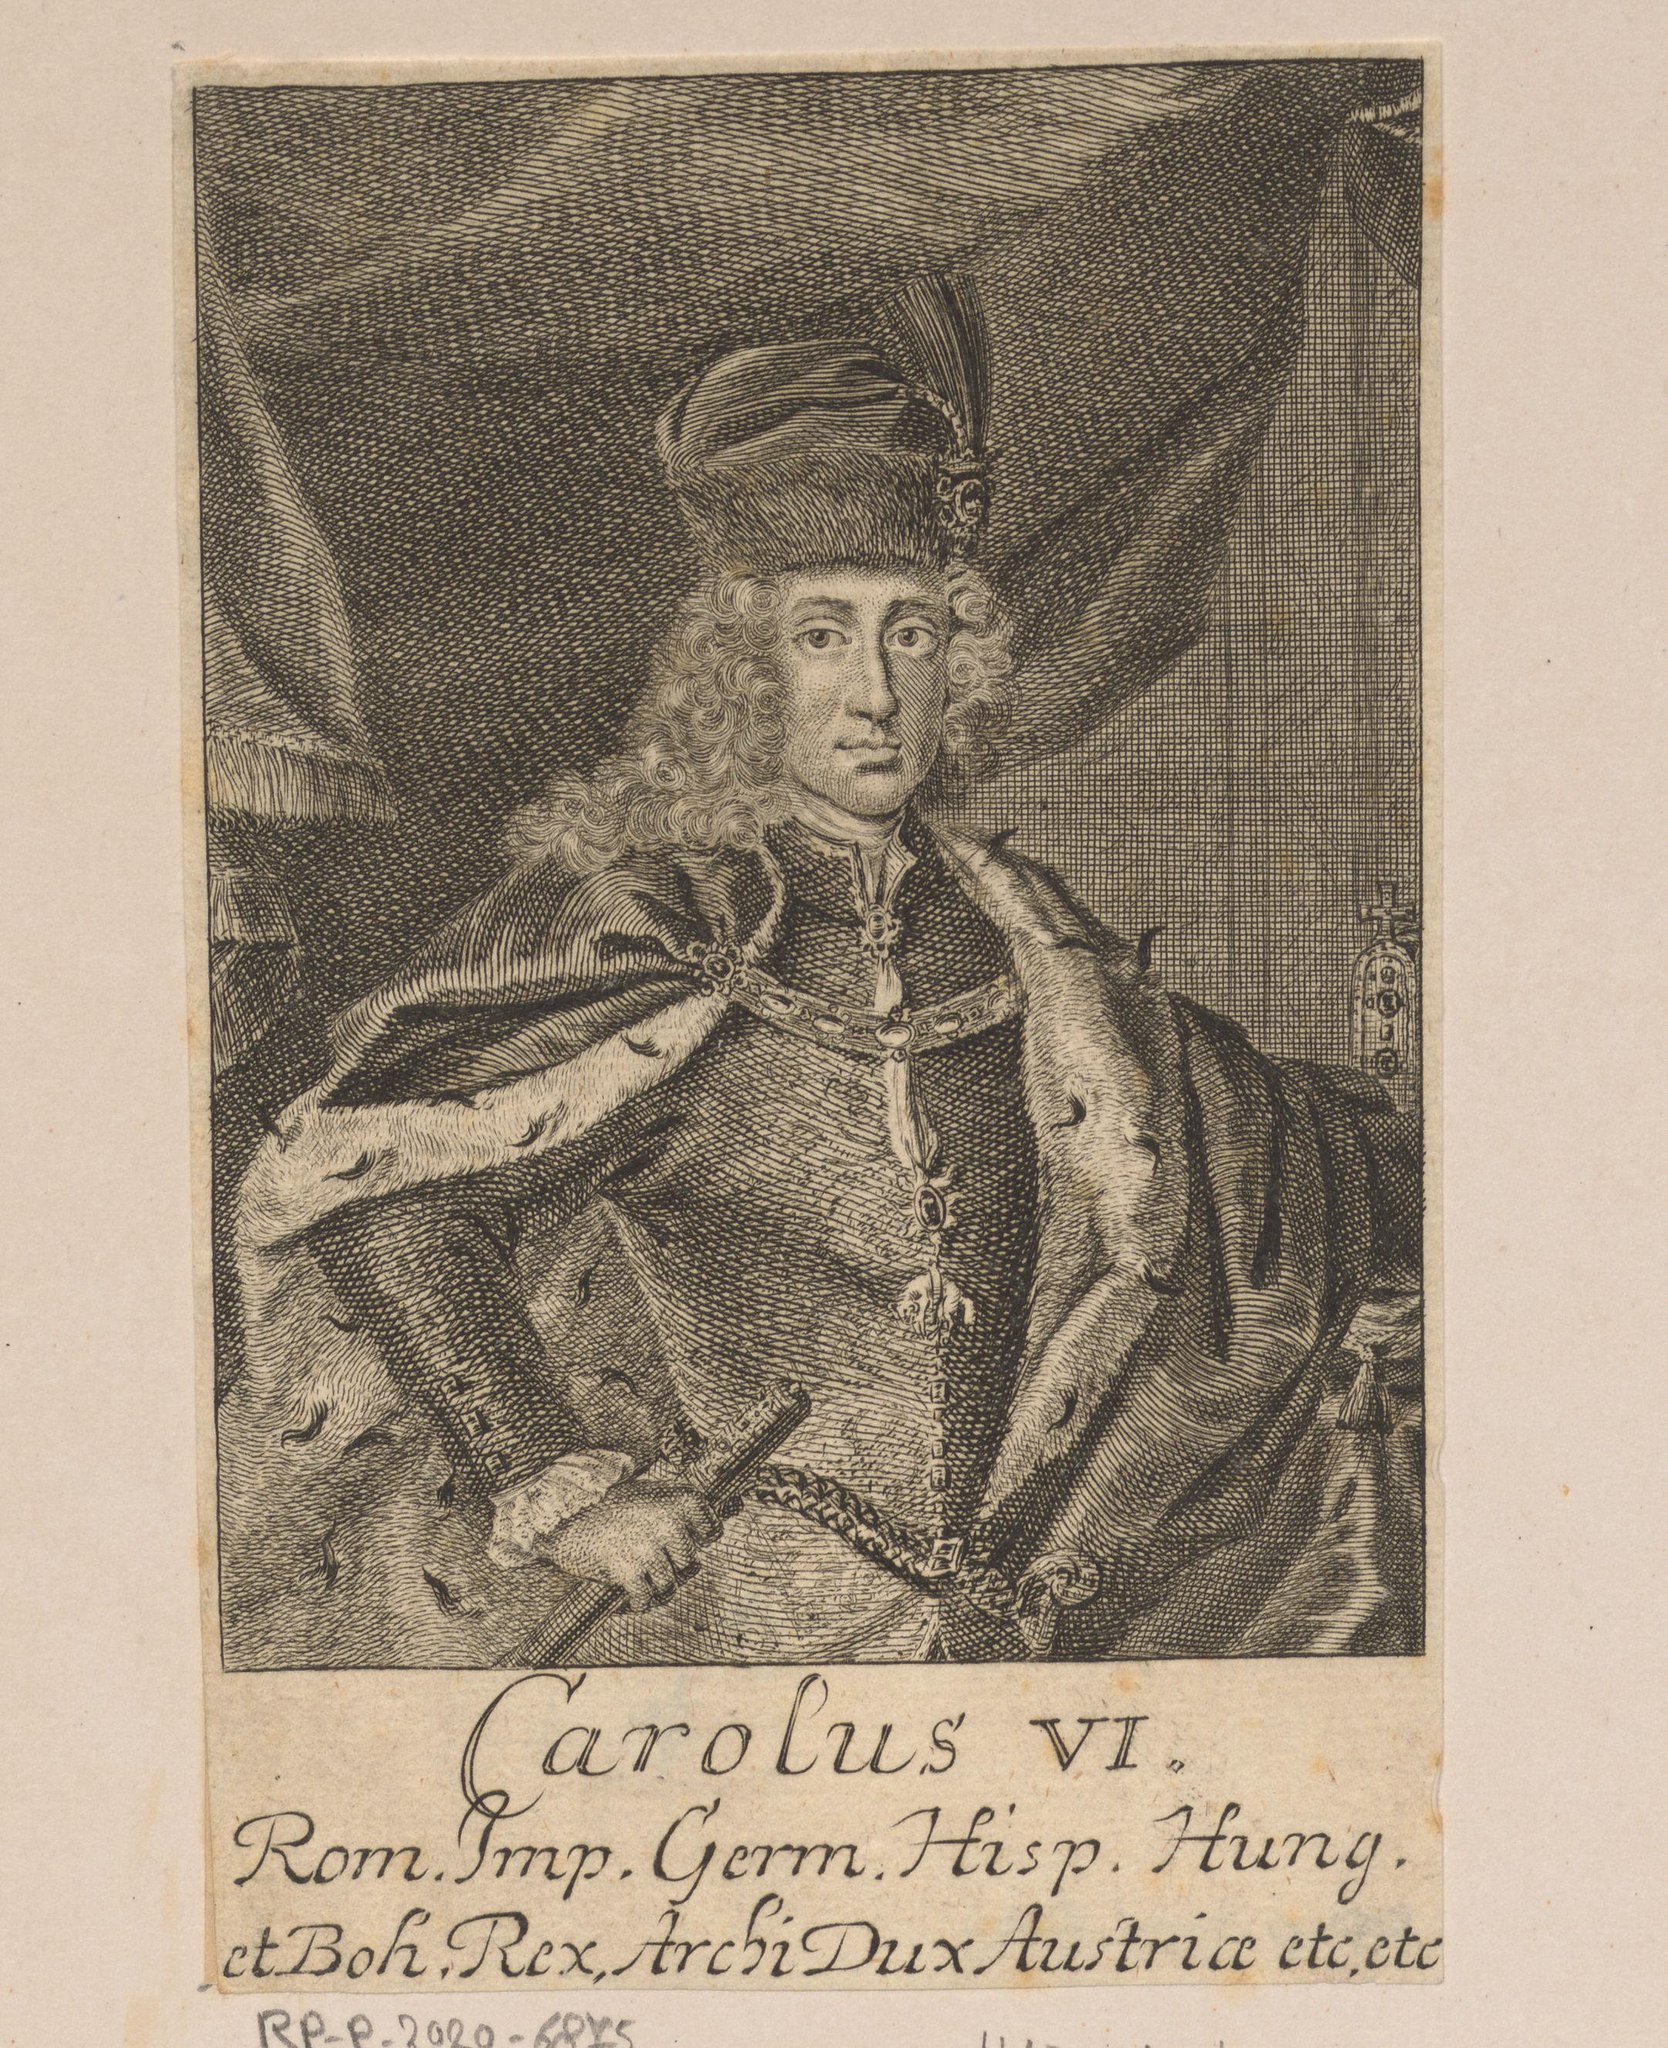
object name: print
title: Portret van keizer Karel VI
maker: martin bernigeroth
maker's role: print maker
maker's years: 1670-1733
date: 1712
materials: paper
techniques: engraving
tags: vienna, charles vi (holy roman emperor), historical persons, emperor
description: Prent mogelijk uit: Die Europäische Fama, Welche den gegenwärtigen Zustand der vornehmsten Höfe entdecket. Leipzig: Johann Ludwig Gleditsch, en Johann Friedrich Gleditsch, 1712, dl. 137.